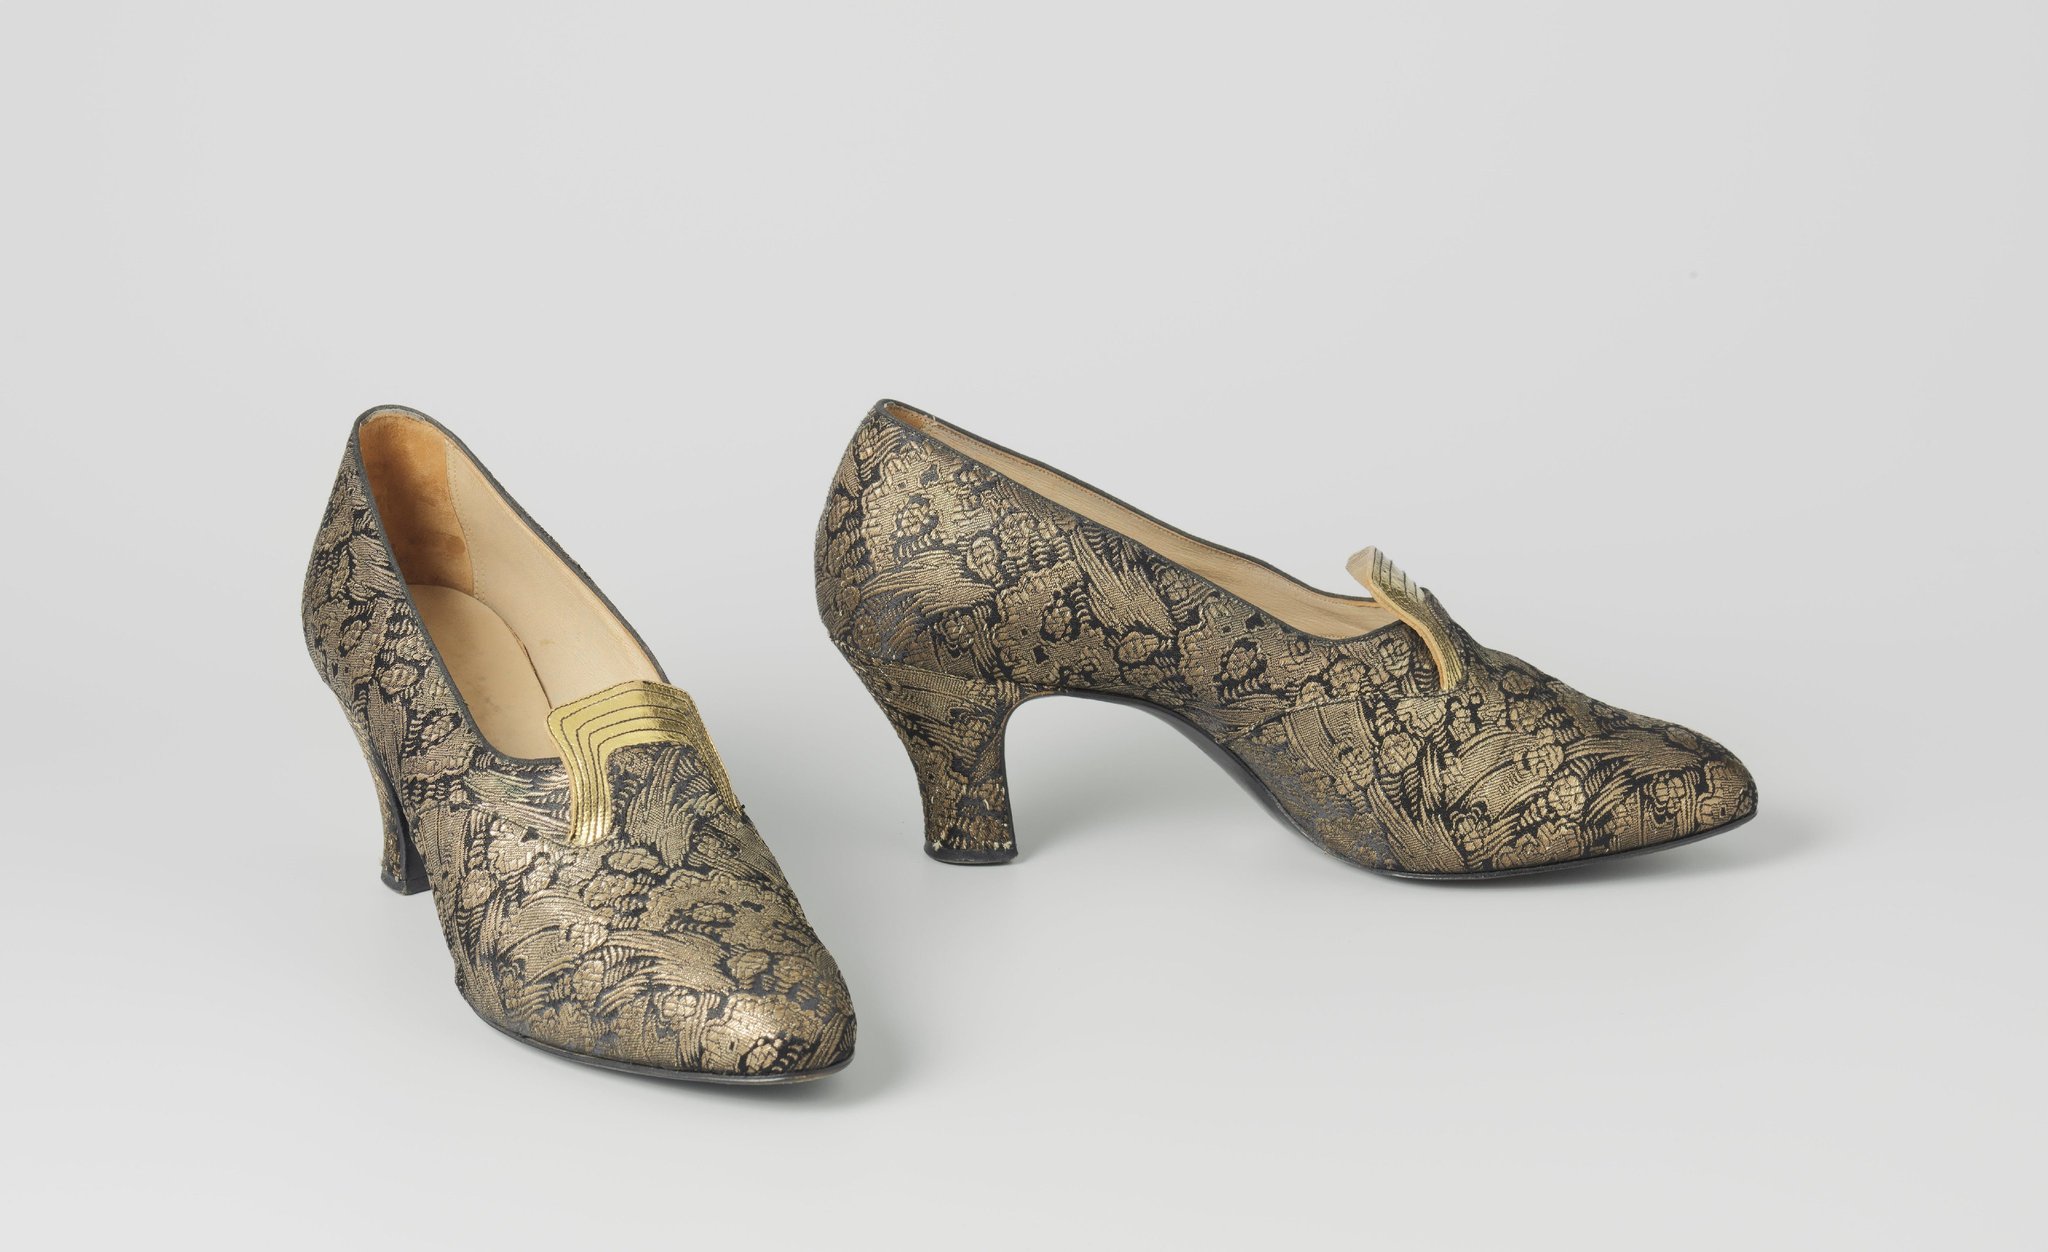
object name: avondschoen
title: Pair of women’s shoes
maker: Anonymous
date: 1920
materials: leather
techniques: brocade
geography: western europe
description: Rechterdamesschoen van zwart met goud brokaat. Model: ronde neus, inschiet model met flap van doorgestik goud kleurig leer.. De voorkant van de hak loopt recht naar beneden en is bekleed met hetzelfde leer als de zool.. De zijkant en de achterkant van de hak zijn getailleerd en bekleed met brokaat. De schoen is met linnen gevoerd in de voet, met leverkleurig leer aan de zijkant en in de hierl met lichtbruin suede.